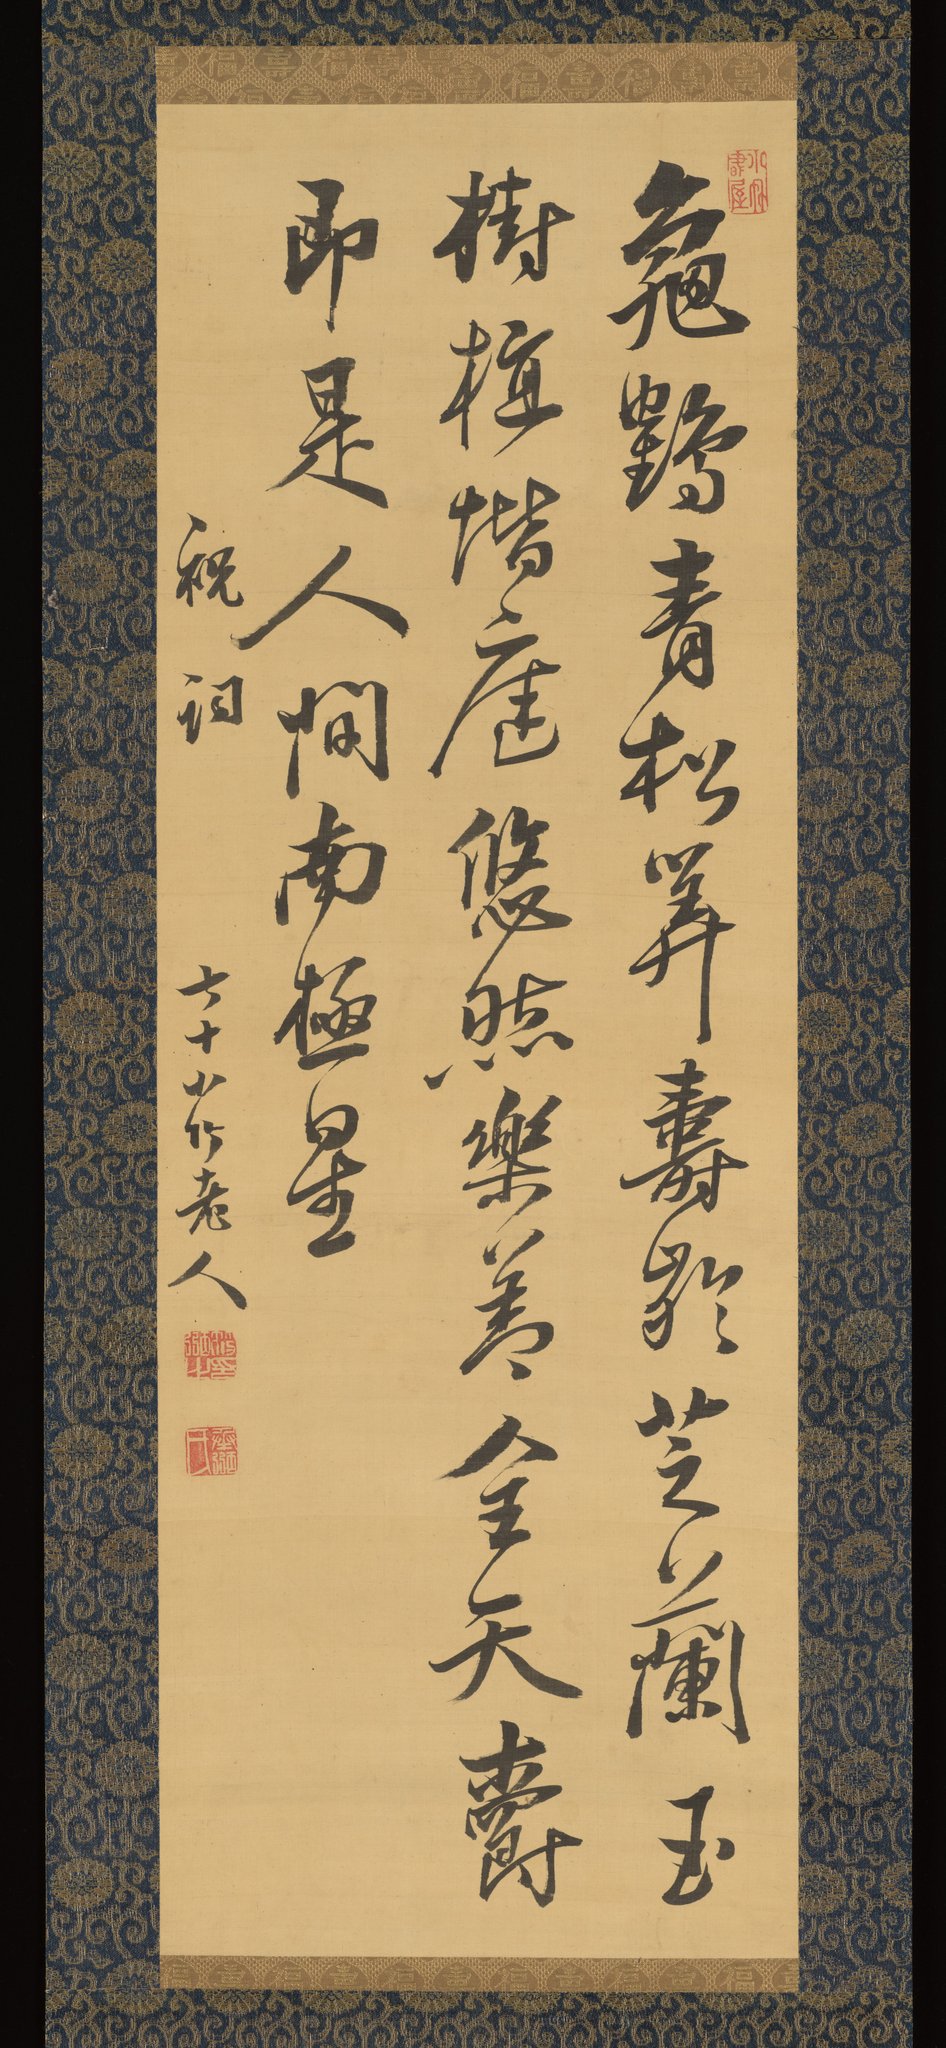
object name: hanging scroll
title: Three-Line Calligraphy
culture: japanese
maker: shinozaki shōchiku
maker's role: artist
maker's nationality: japanese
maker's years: 1781-1851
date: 1615-1868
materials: ink, paper